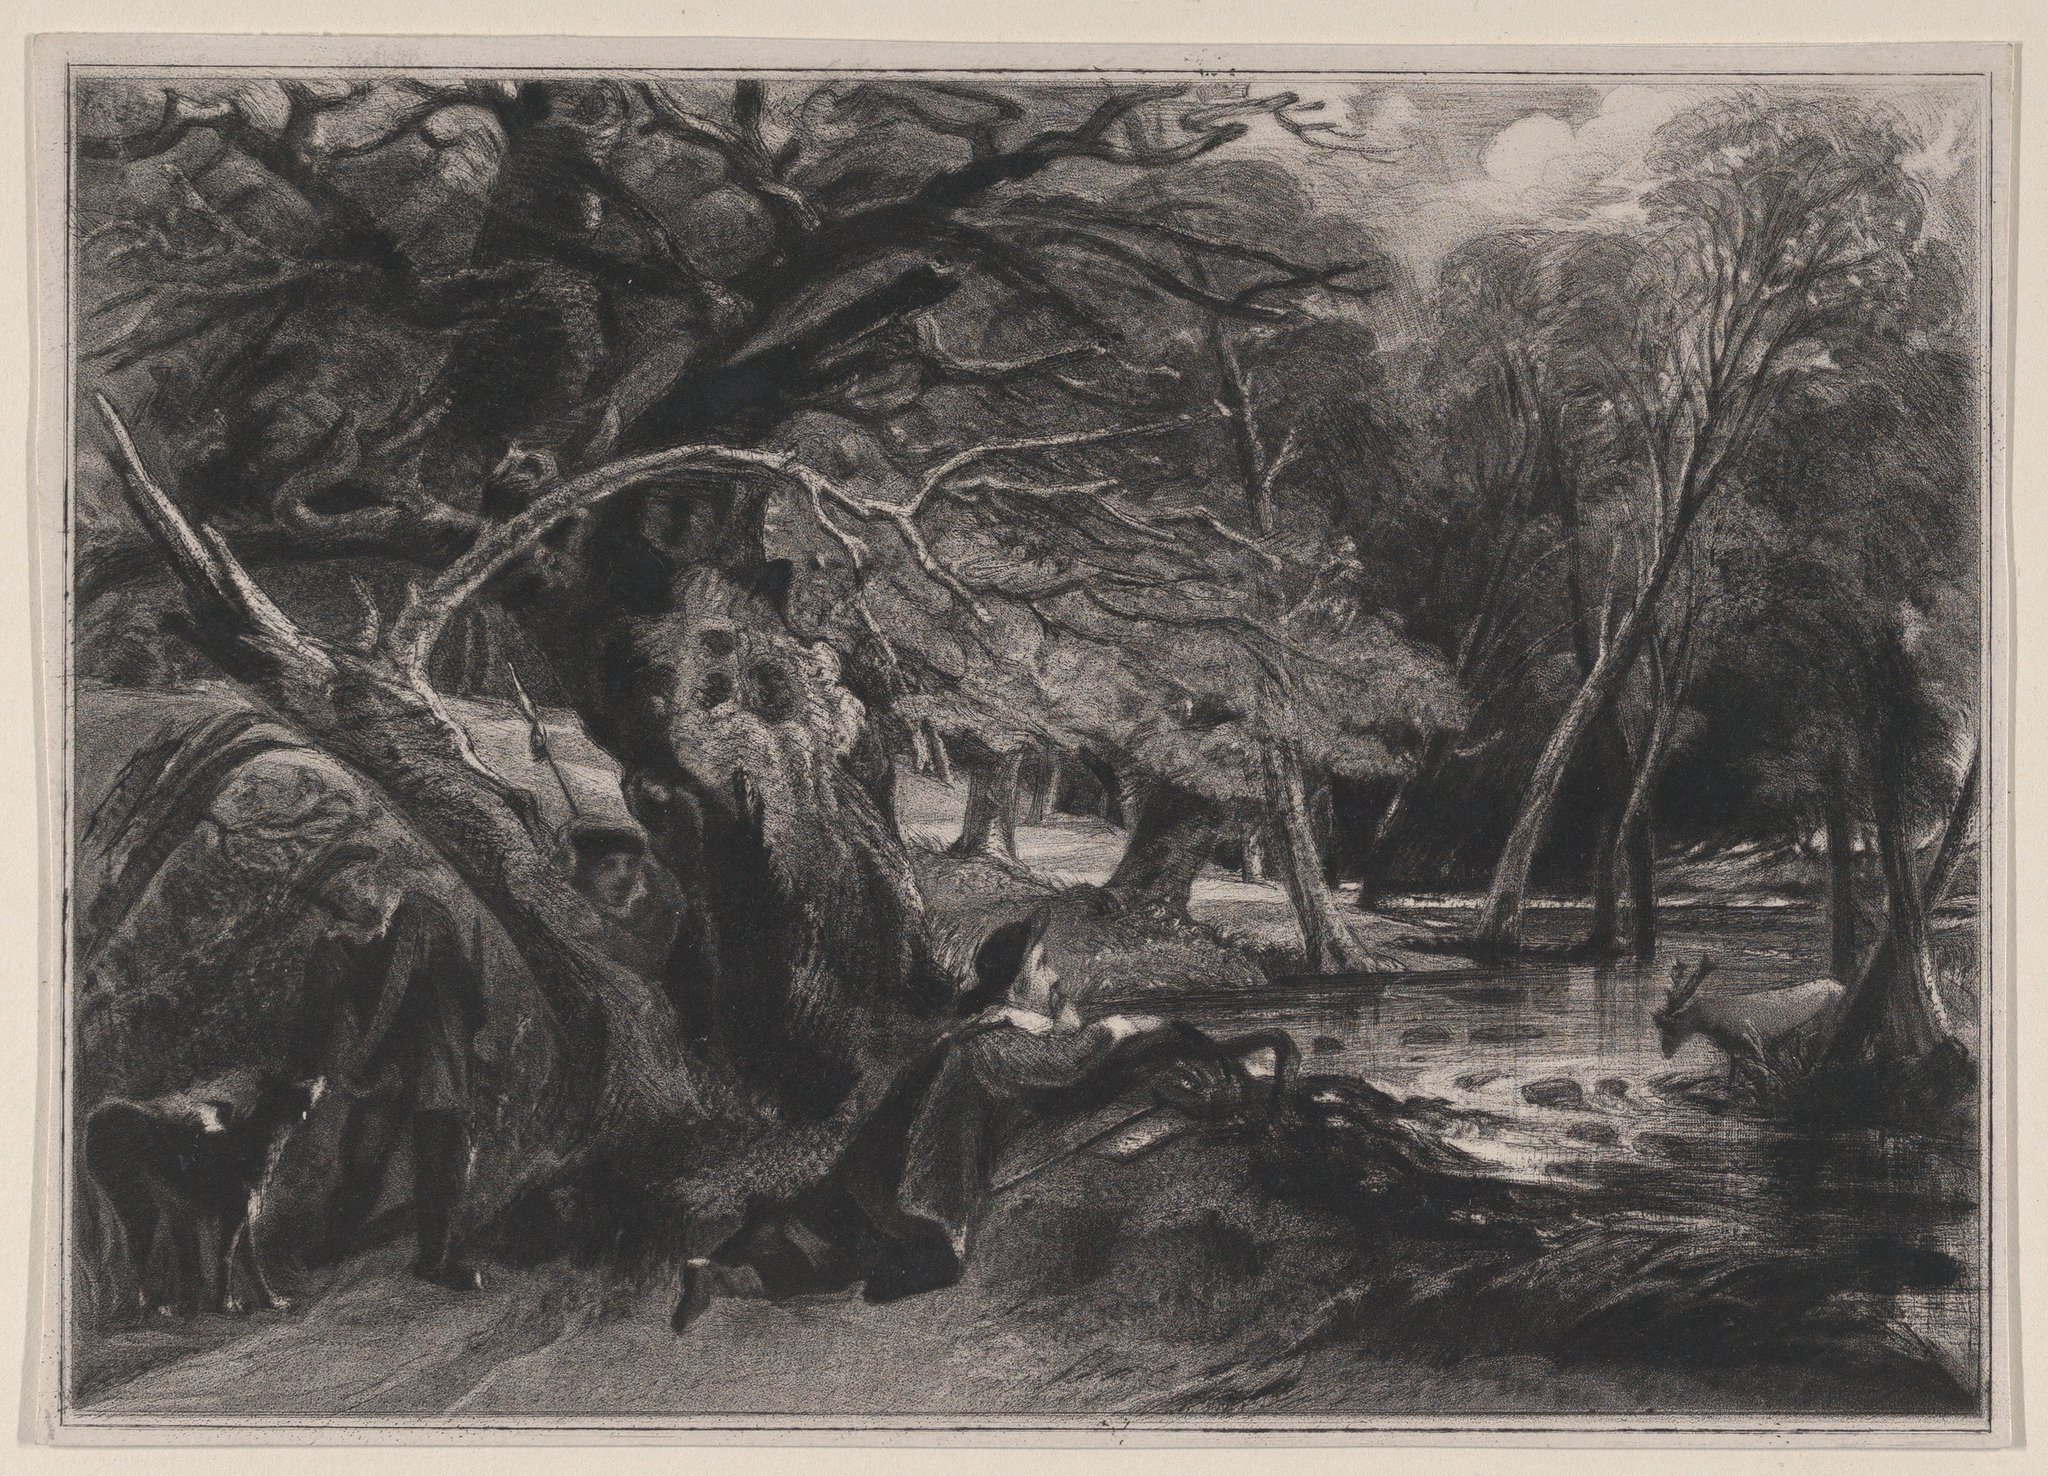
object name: print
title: Jacques and the Wounded Stag (Shakespeare, As You Like It, Act 2, Scene 1)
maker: david lucas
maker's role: engraver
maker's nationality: british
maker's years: 1802-1881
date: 1830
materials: chalk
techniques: mezzotint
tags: animals,shakespeare,men,hunting,forests